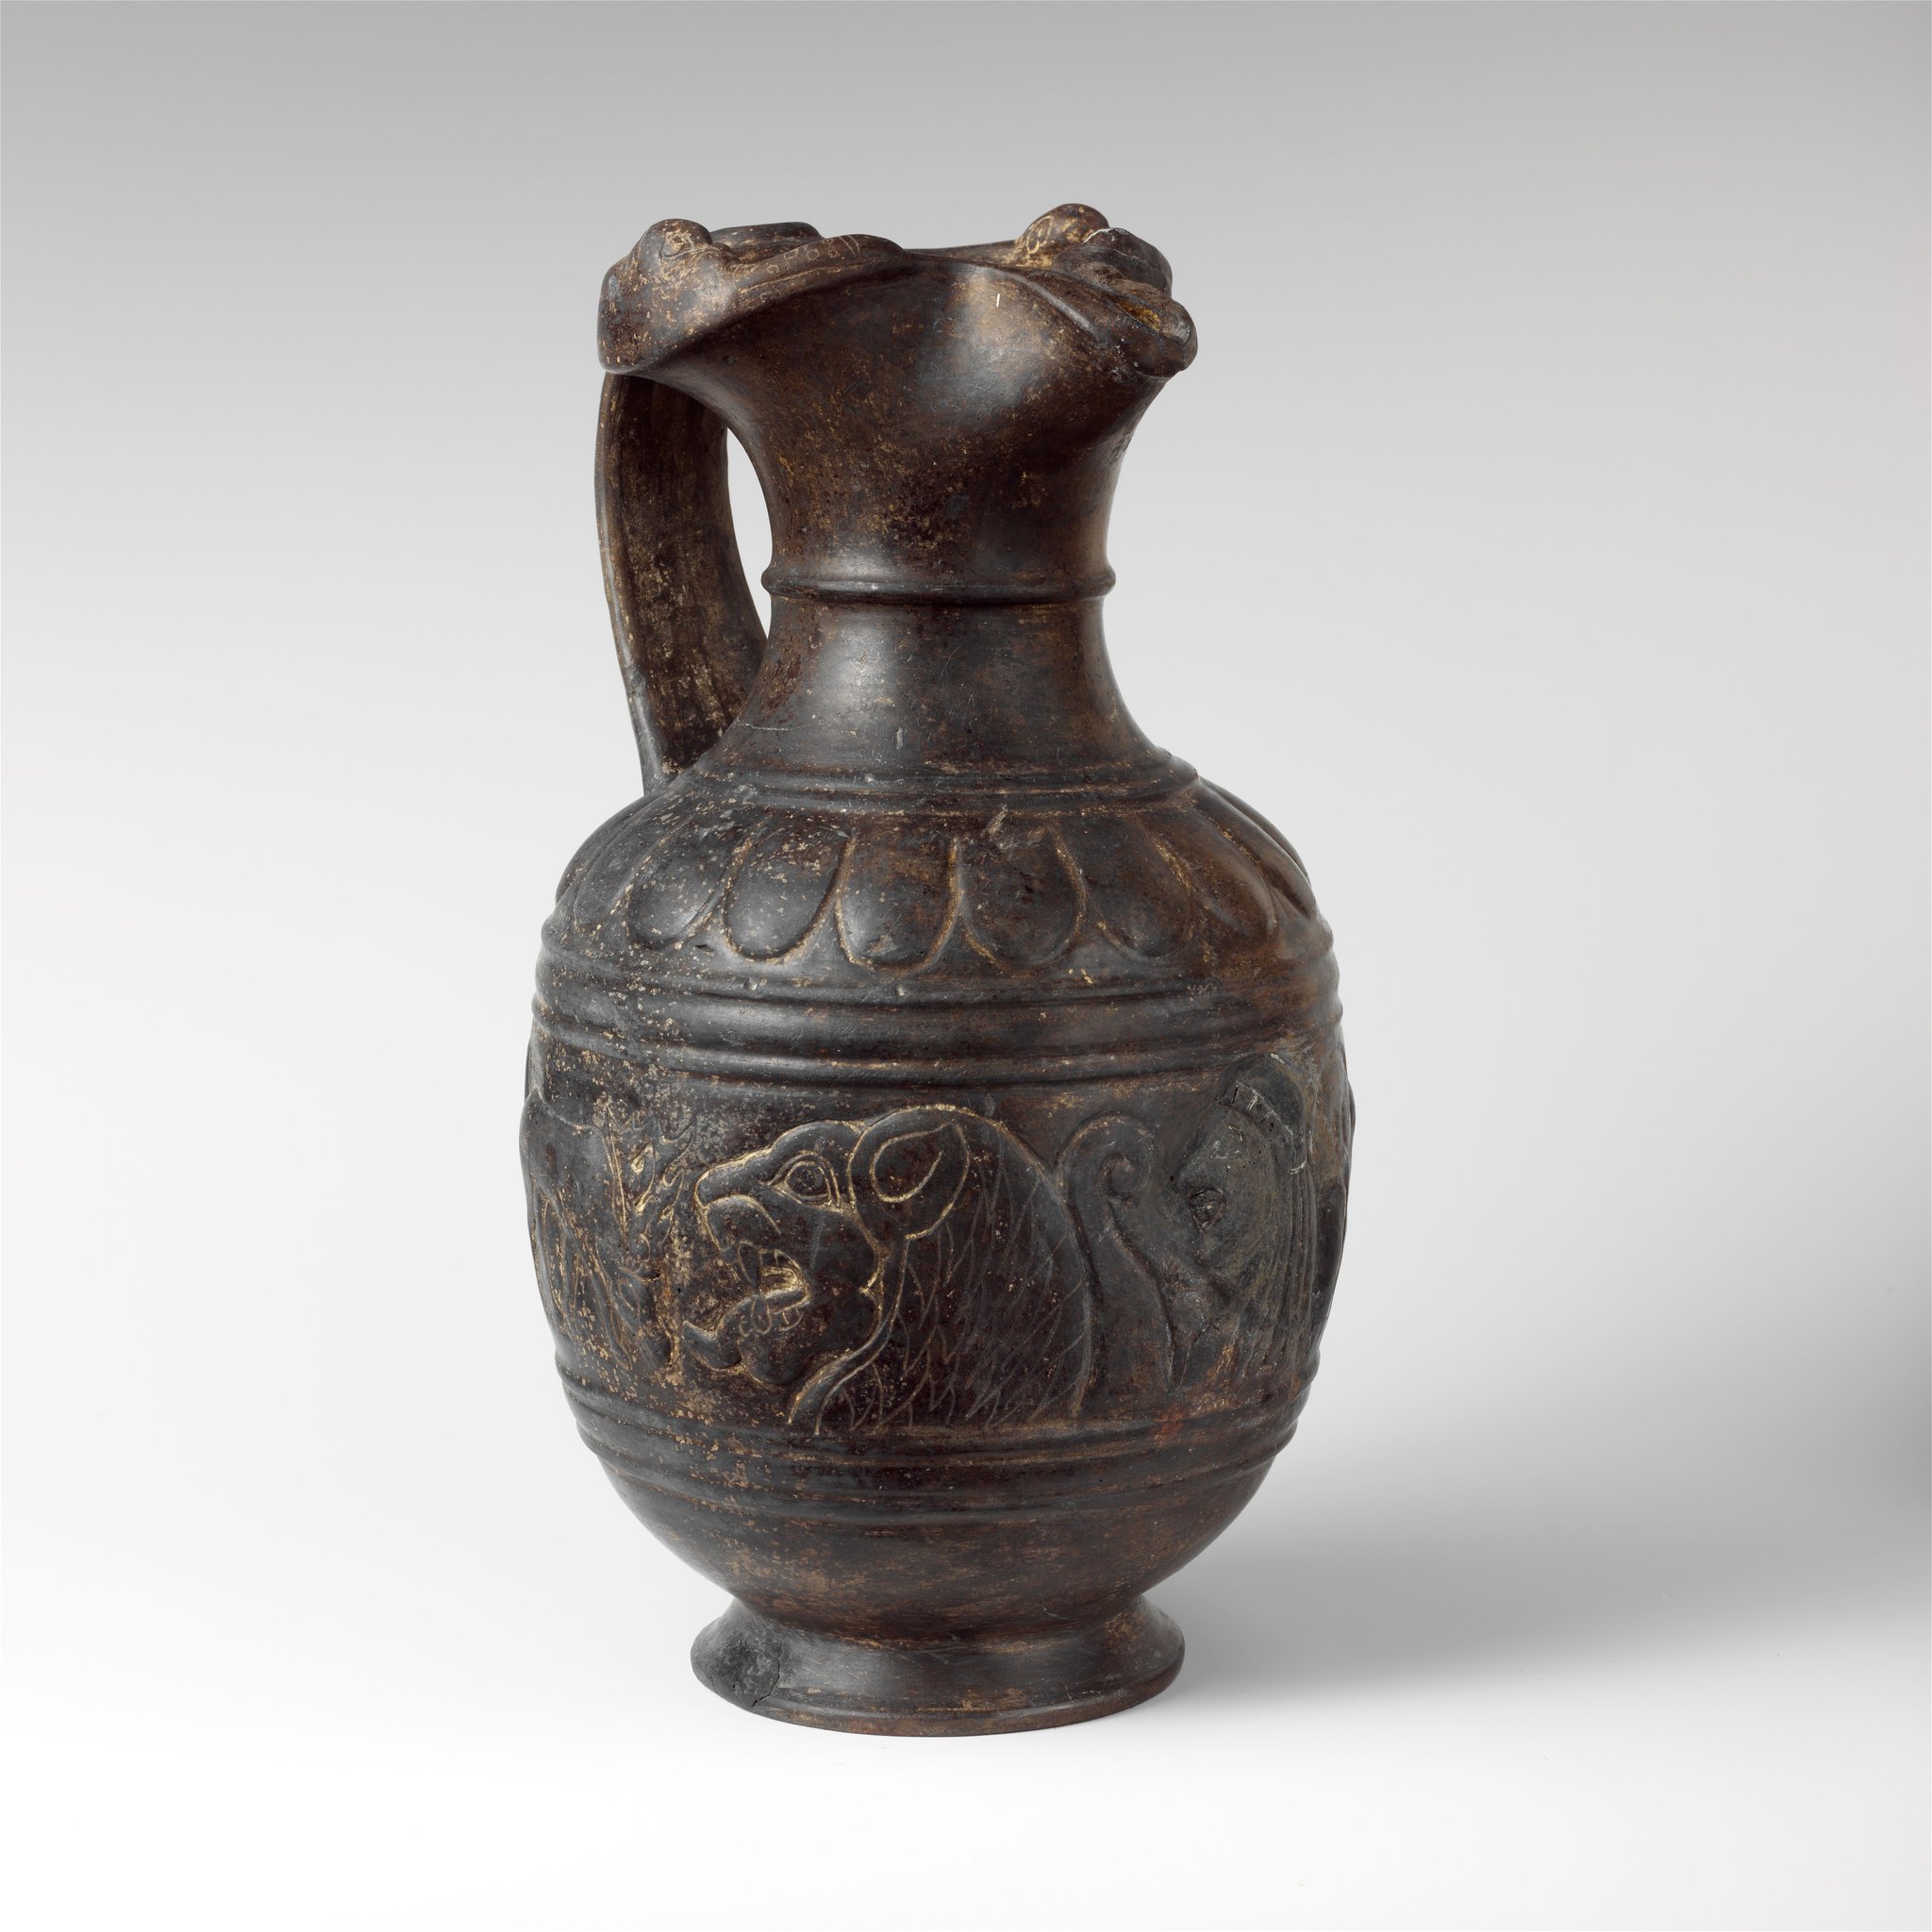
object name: oinochoe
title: Terracotta oinochoe (jug)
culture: etruscan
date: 550 BCE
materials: terracotta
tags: heads,lions